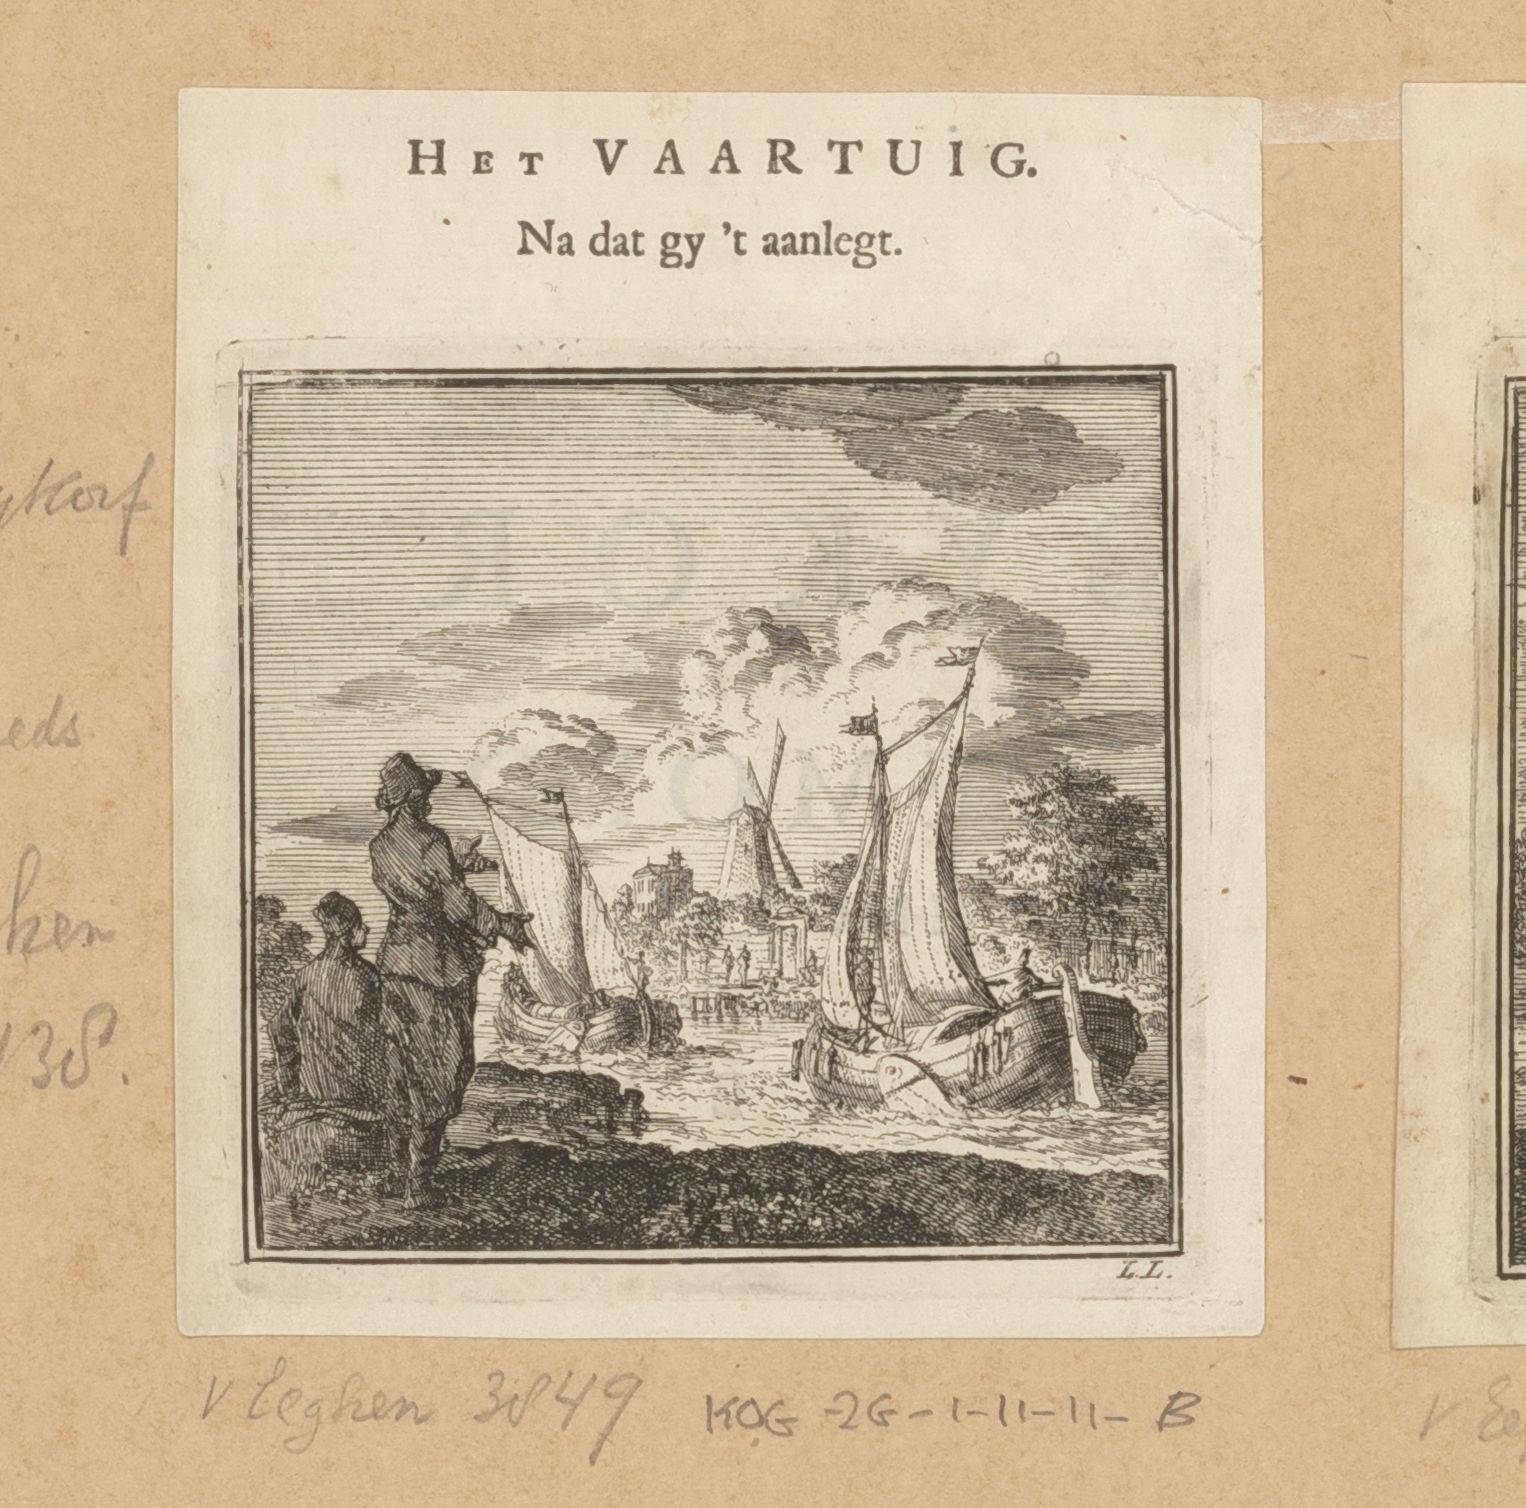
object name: print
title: Twee platbodems varen op een rivier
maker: jan luyken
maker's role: draughtsman, print maker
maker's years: 1649-1712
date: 1709-1711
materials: paper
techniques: etching, letterpress printing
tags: sailing-ship, sailing-boat, windmill in landscape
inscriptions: collector's mark: Lugt 1641, stamp, stamp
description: Onderwerpsrubrieken binnen de Atlas Zeden en Gewoonten: Handel, nijverheid en verkeer, Vervoermiddelen te land en te water, Vervoermiddelen te water.